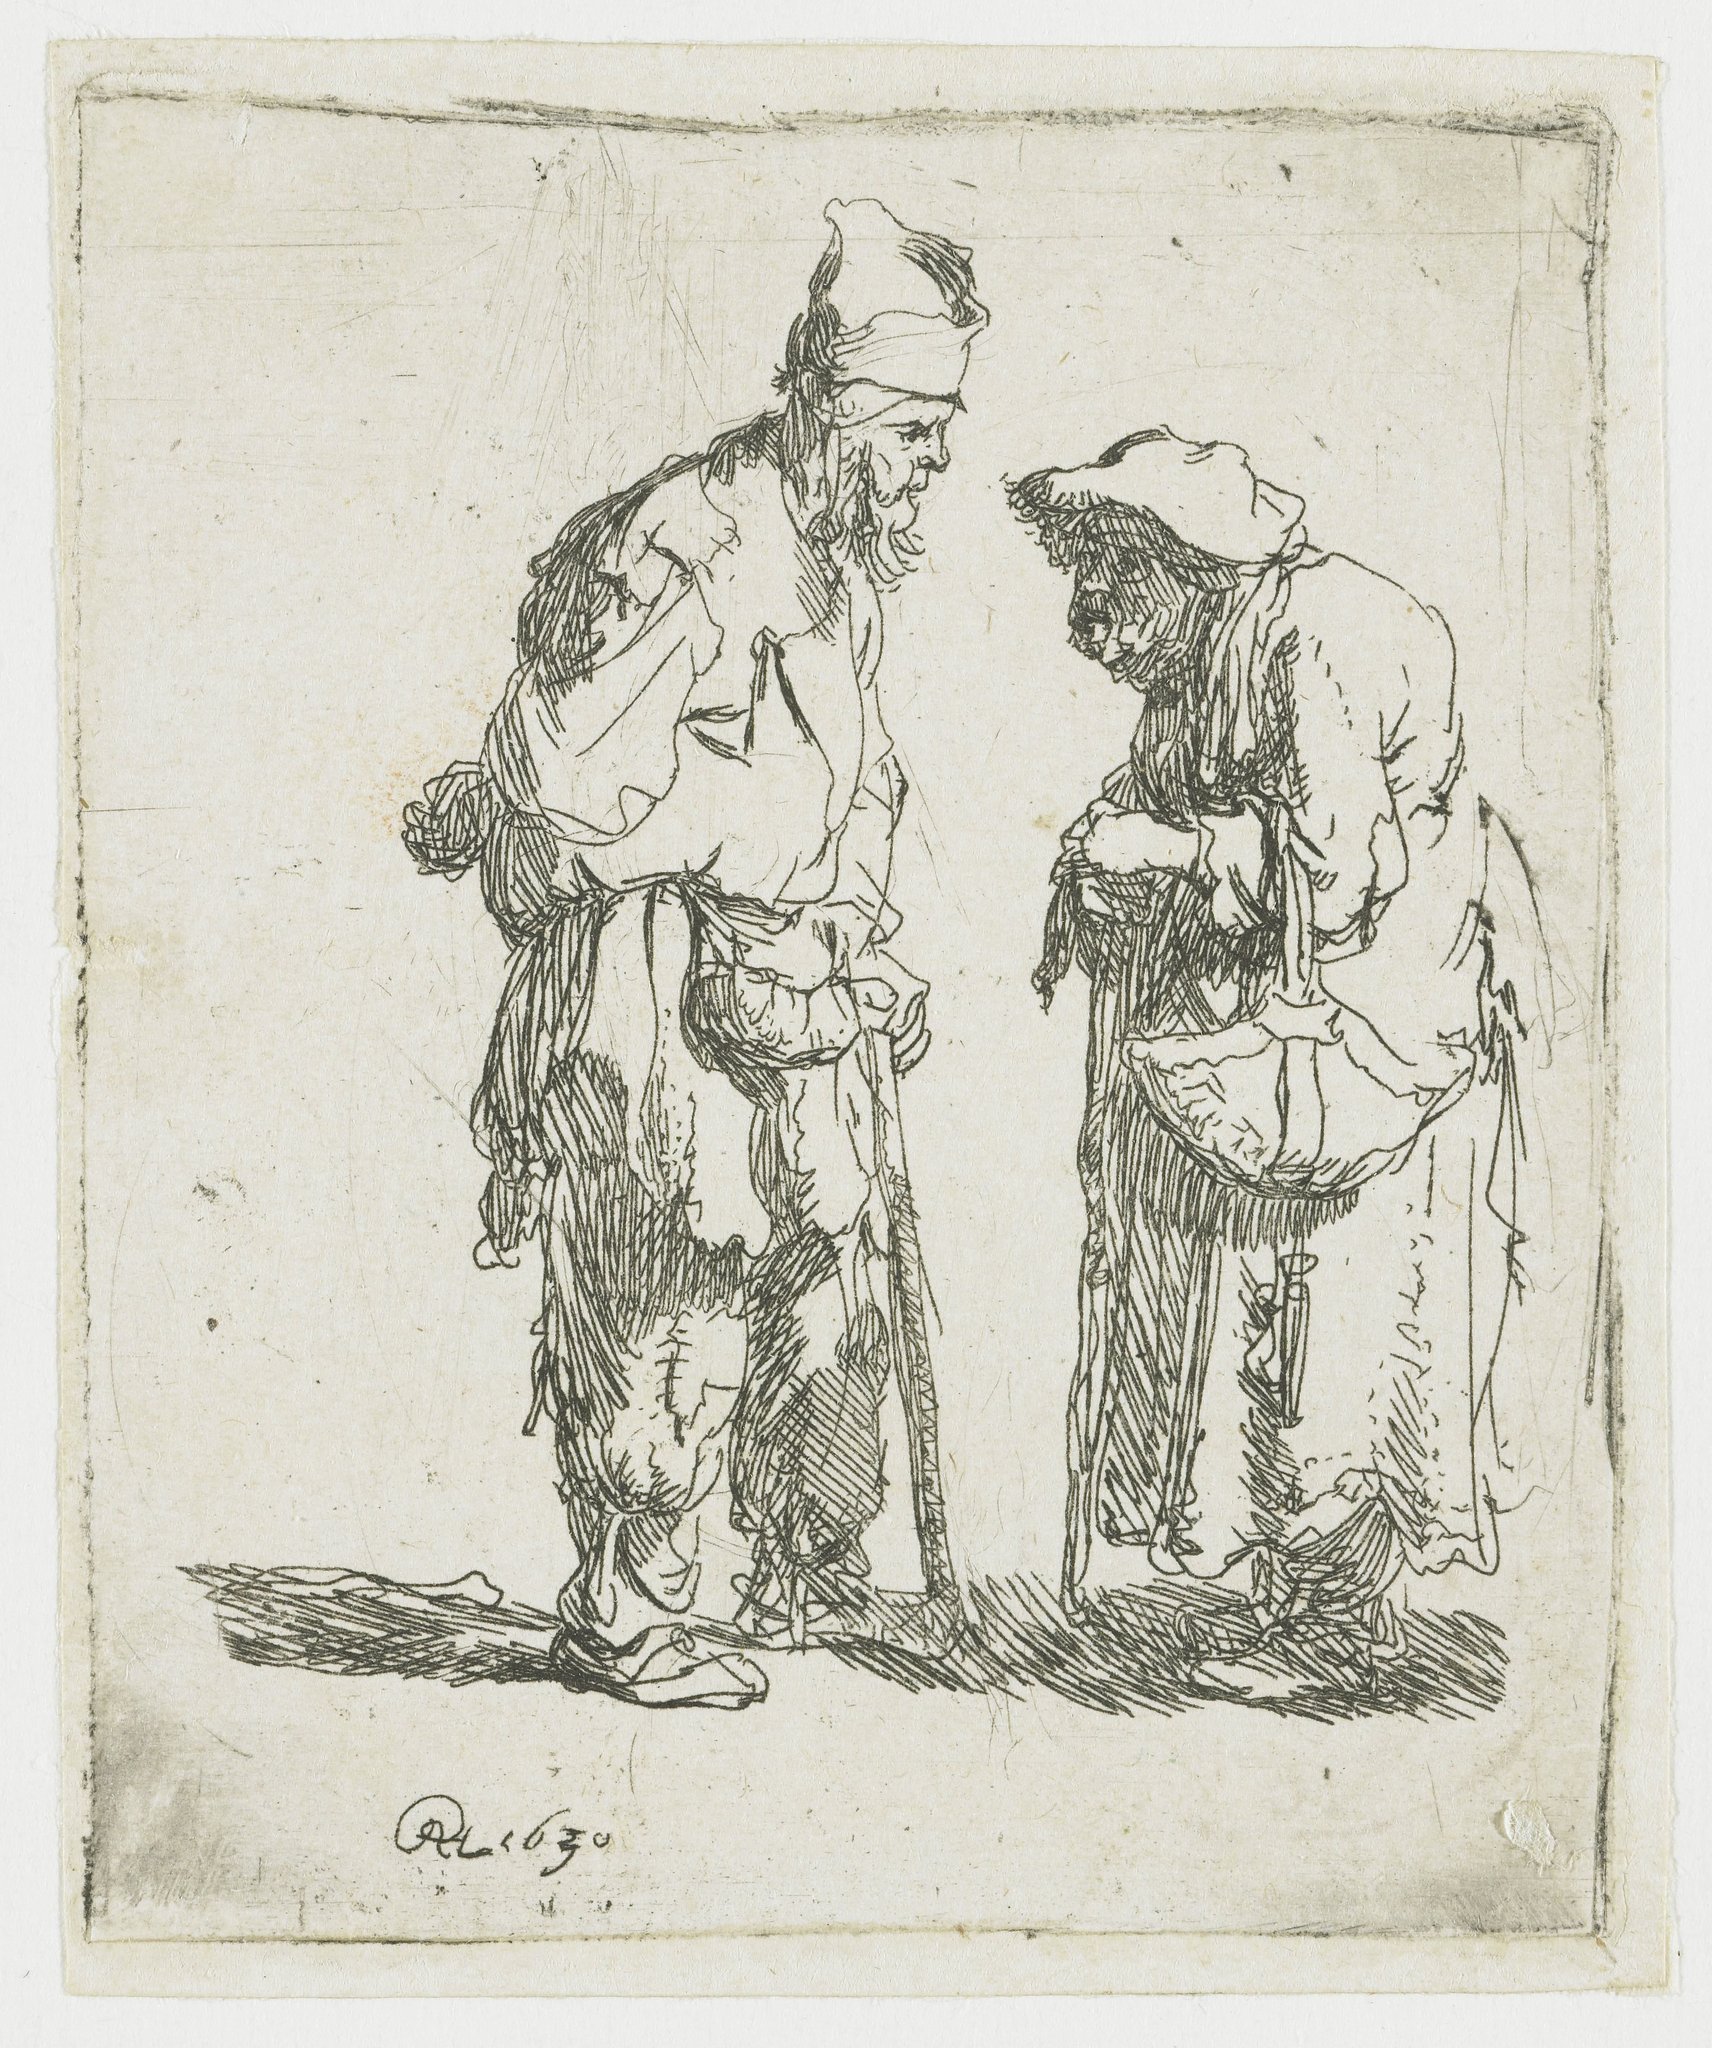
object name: print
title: Beggar Man and Woman Conversing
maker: rembrandt van rijn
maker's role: draughtsman, painter, print maker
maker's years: 1606-1669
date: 1630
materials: paper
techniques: etching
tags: beggar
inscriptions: monogram and date: ‘RHL 1630’, collector's mark: Lugt 240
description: Rembrandt’s rapid progress as a printmaker is easy to see in this group of poor wretches. The seated woman is still somewhat crudely executed, but the beggar woman with a gourd and her male companion already testify to greater mastery of the technique. The little prints of a man and a woman are etched in the finer style that Rembrandt was to develop later.